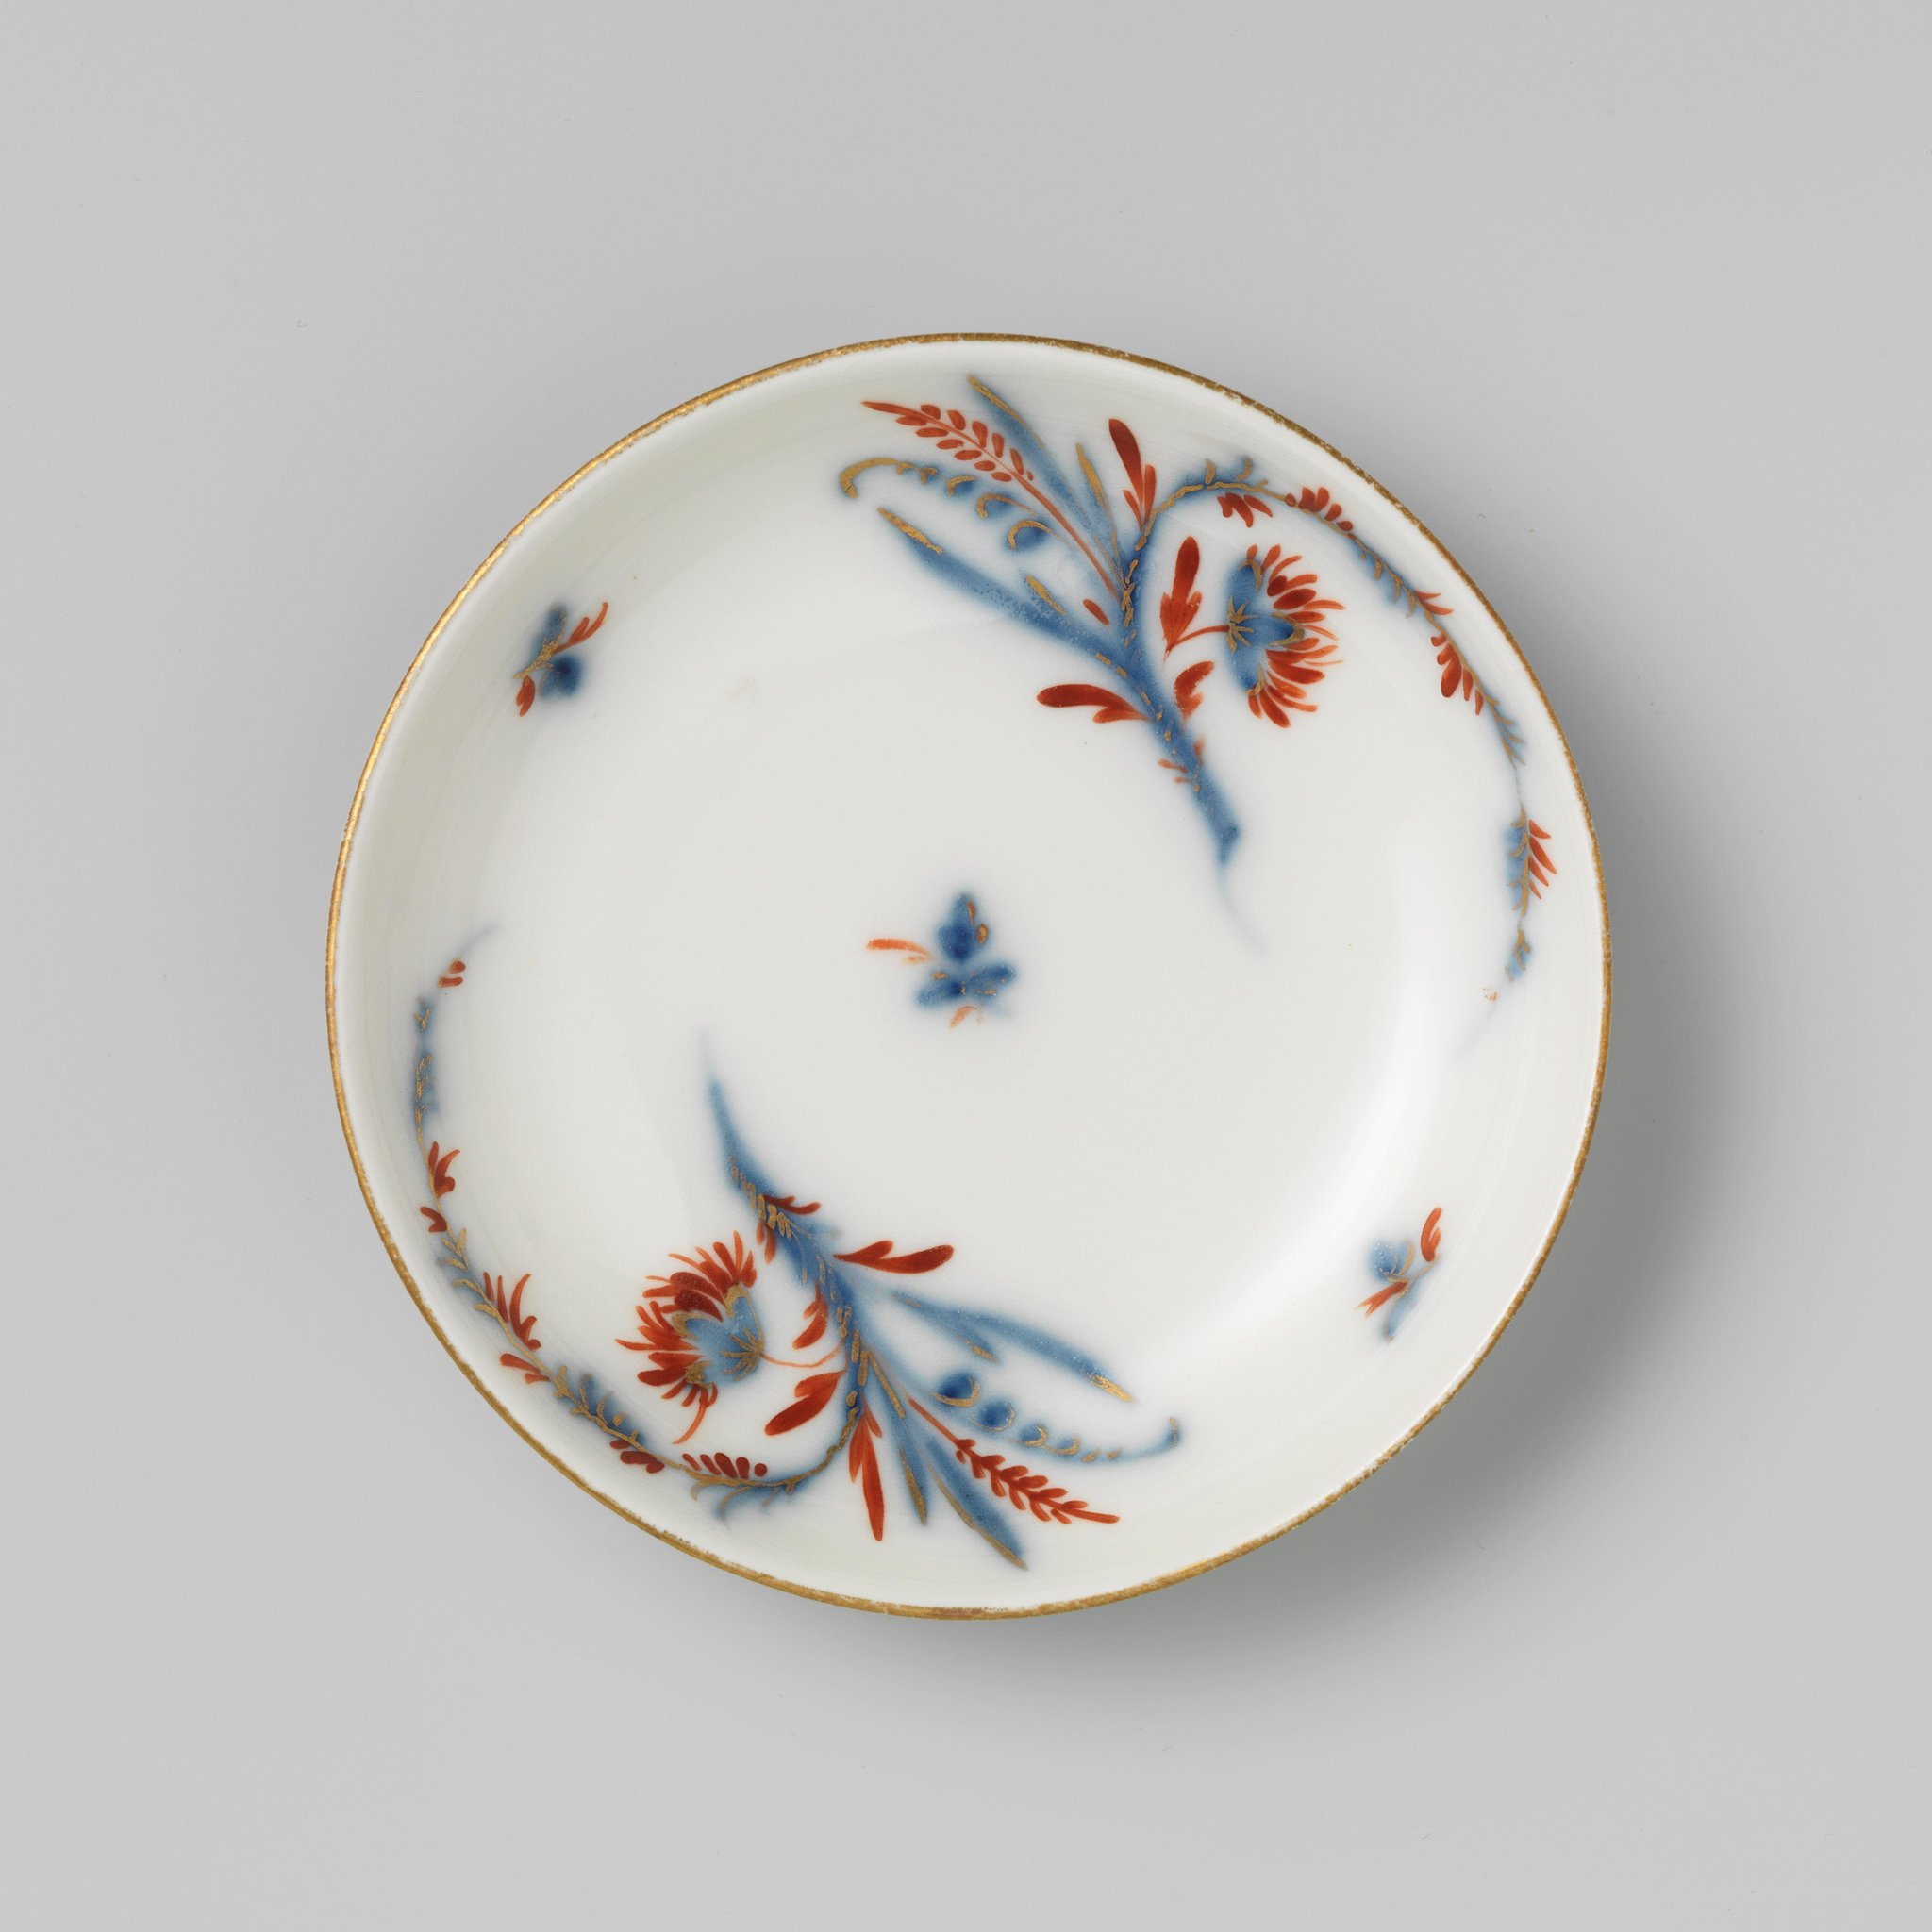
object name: kop en schotel, kop en schotel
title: Schotel, beschilderd met bloemtakken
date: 1778-1782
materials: porcelain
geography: loosdrecht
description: Schotel van porselein. Beschilderd in onderglazuurblauw, rood en goud met bloemtakken.